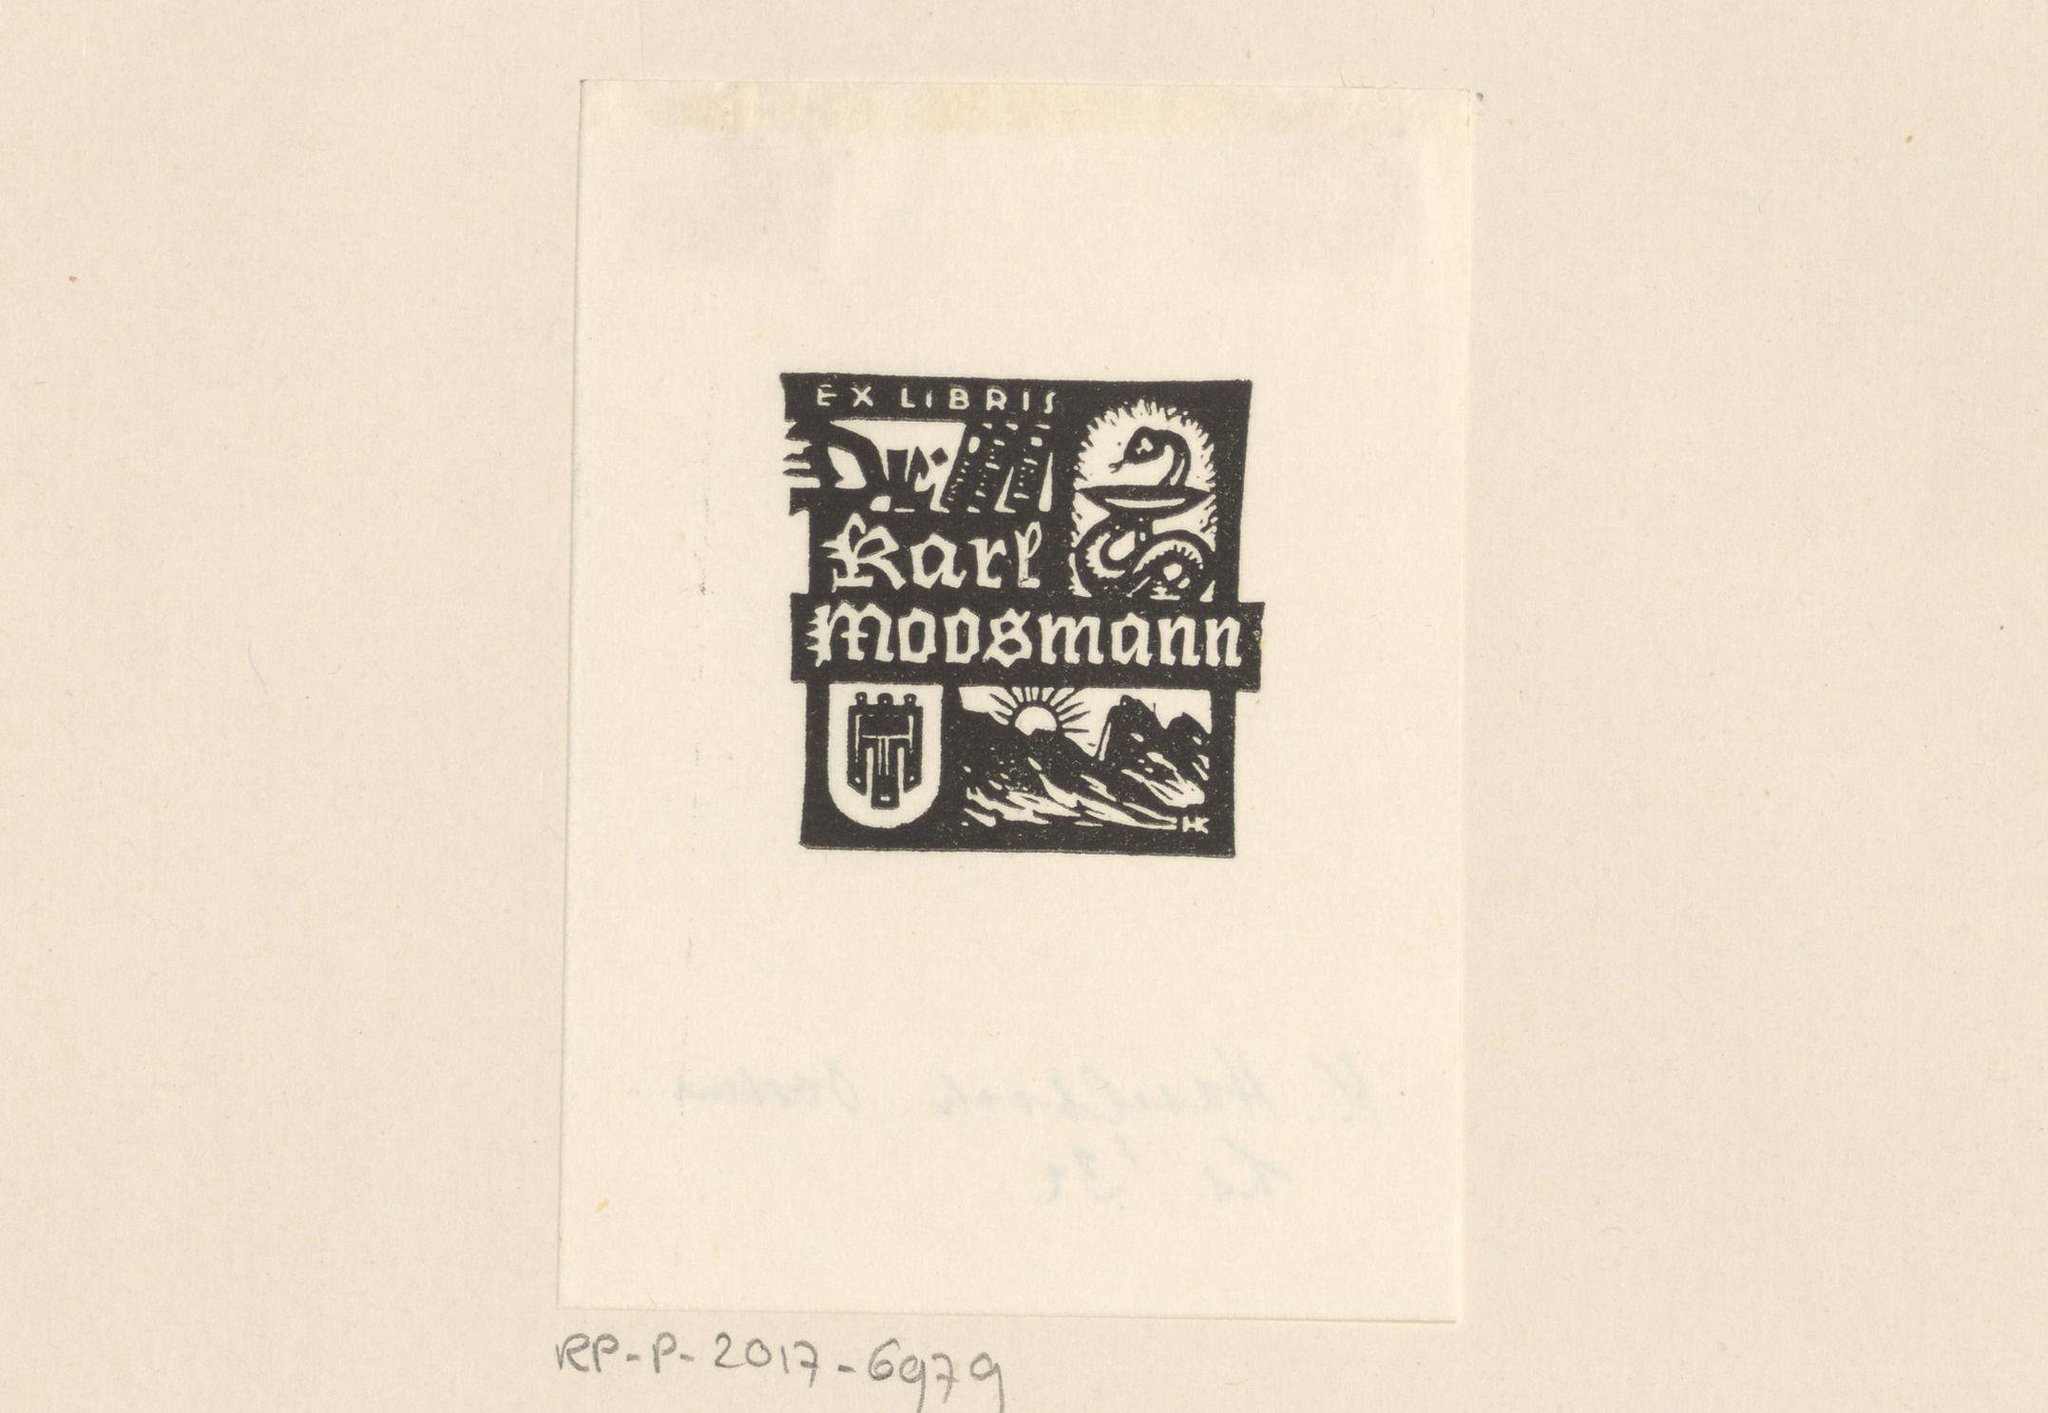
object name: bookplate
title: Ex libris van Karl Moosmann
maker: karl haselböck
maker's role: print maker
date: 1932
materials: paper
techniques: woodcut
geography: austria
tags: aesculapian sign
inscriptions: inscription: ‘K. Haselböck Oosten/ hs. '32’